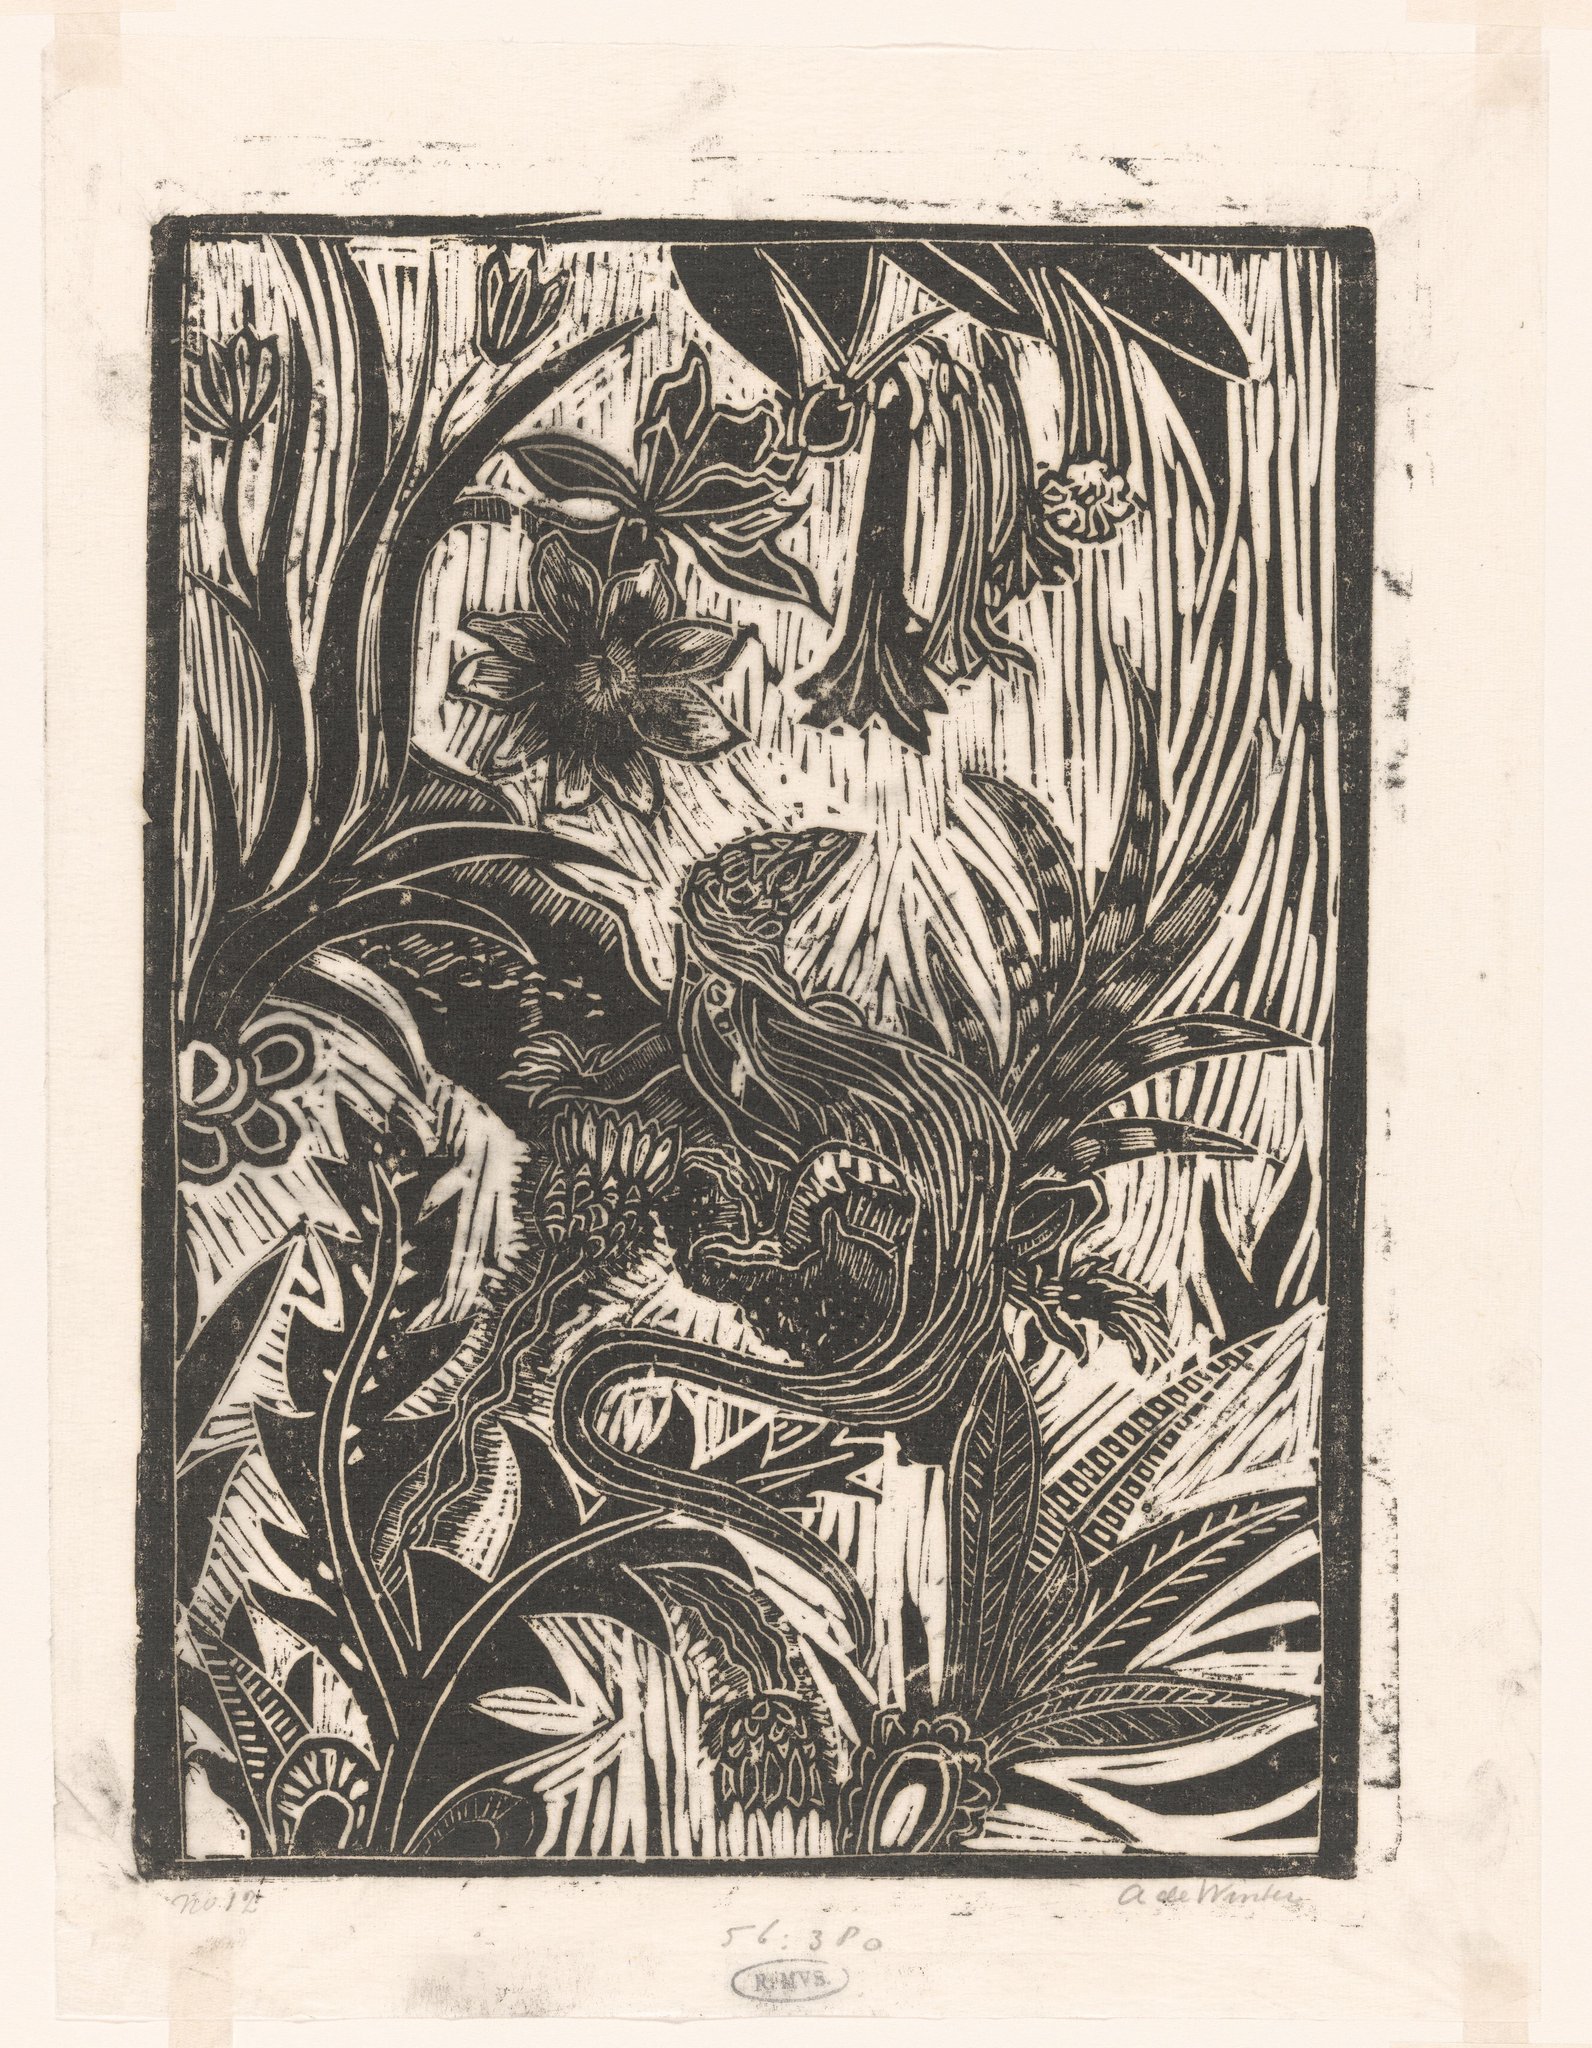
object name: print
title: Hagedis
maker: janus de winter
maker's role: print maker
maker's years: 1882-1951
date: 1892-1951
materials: paper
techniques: linocut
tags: lizards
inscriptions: collector's mark: Lugt 2228, inscription: ‘No 12’